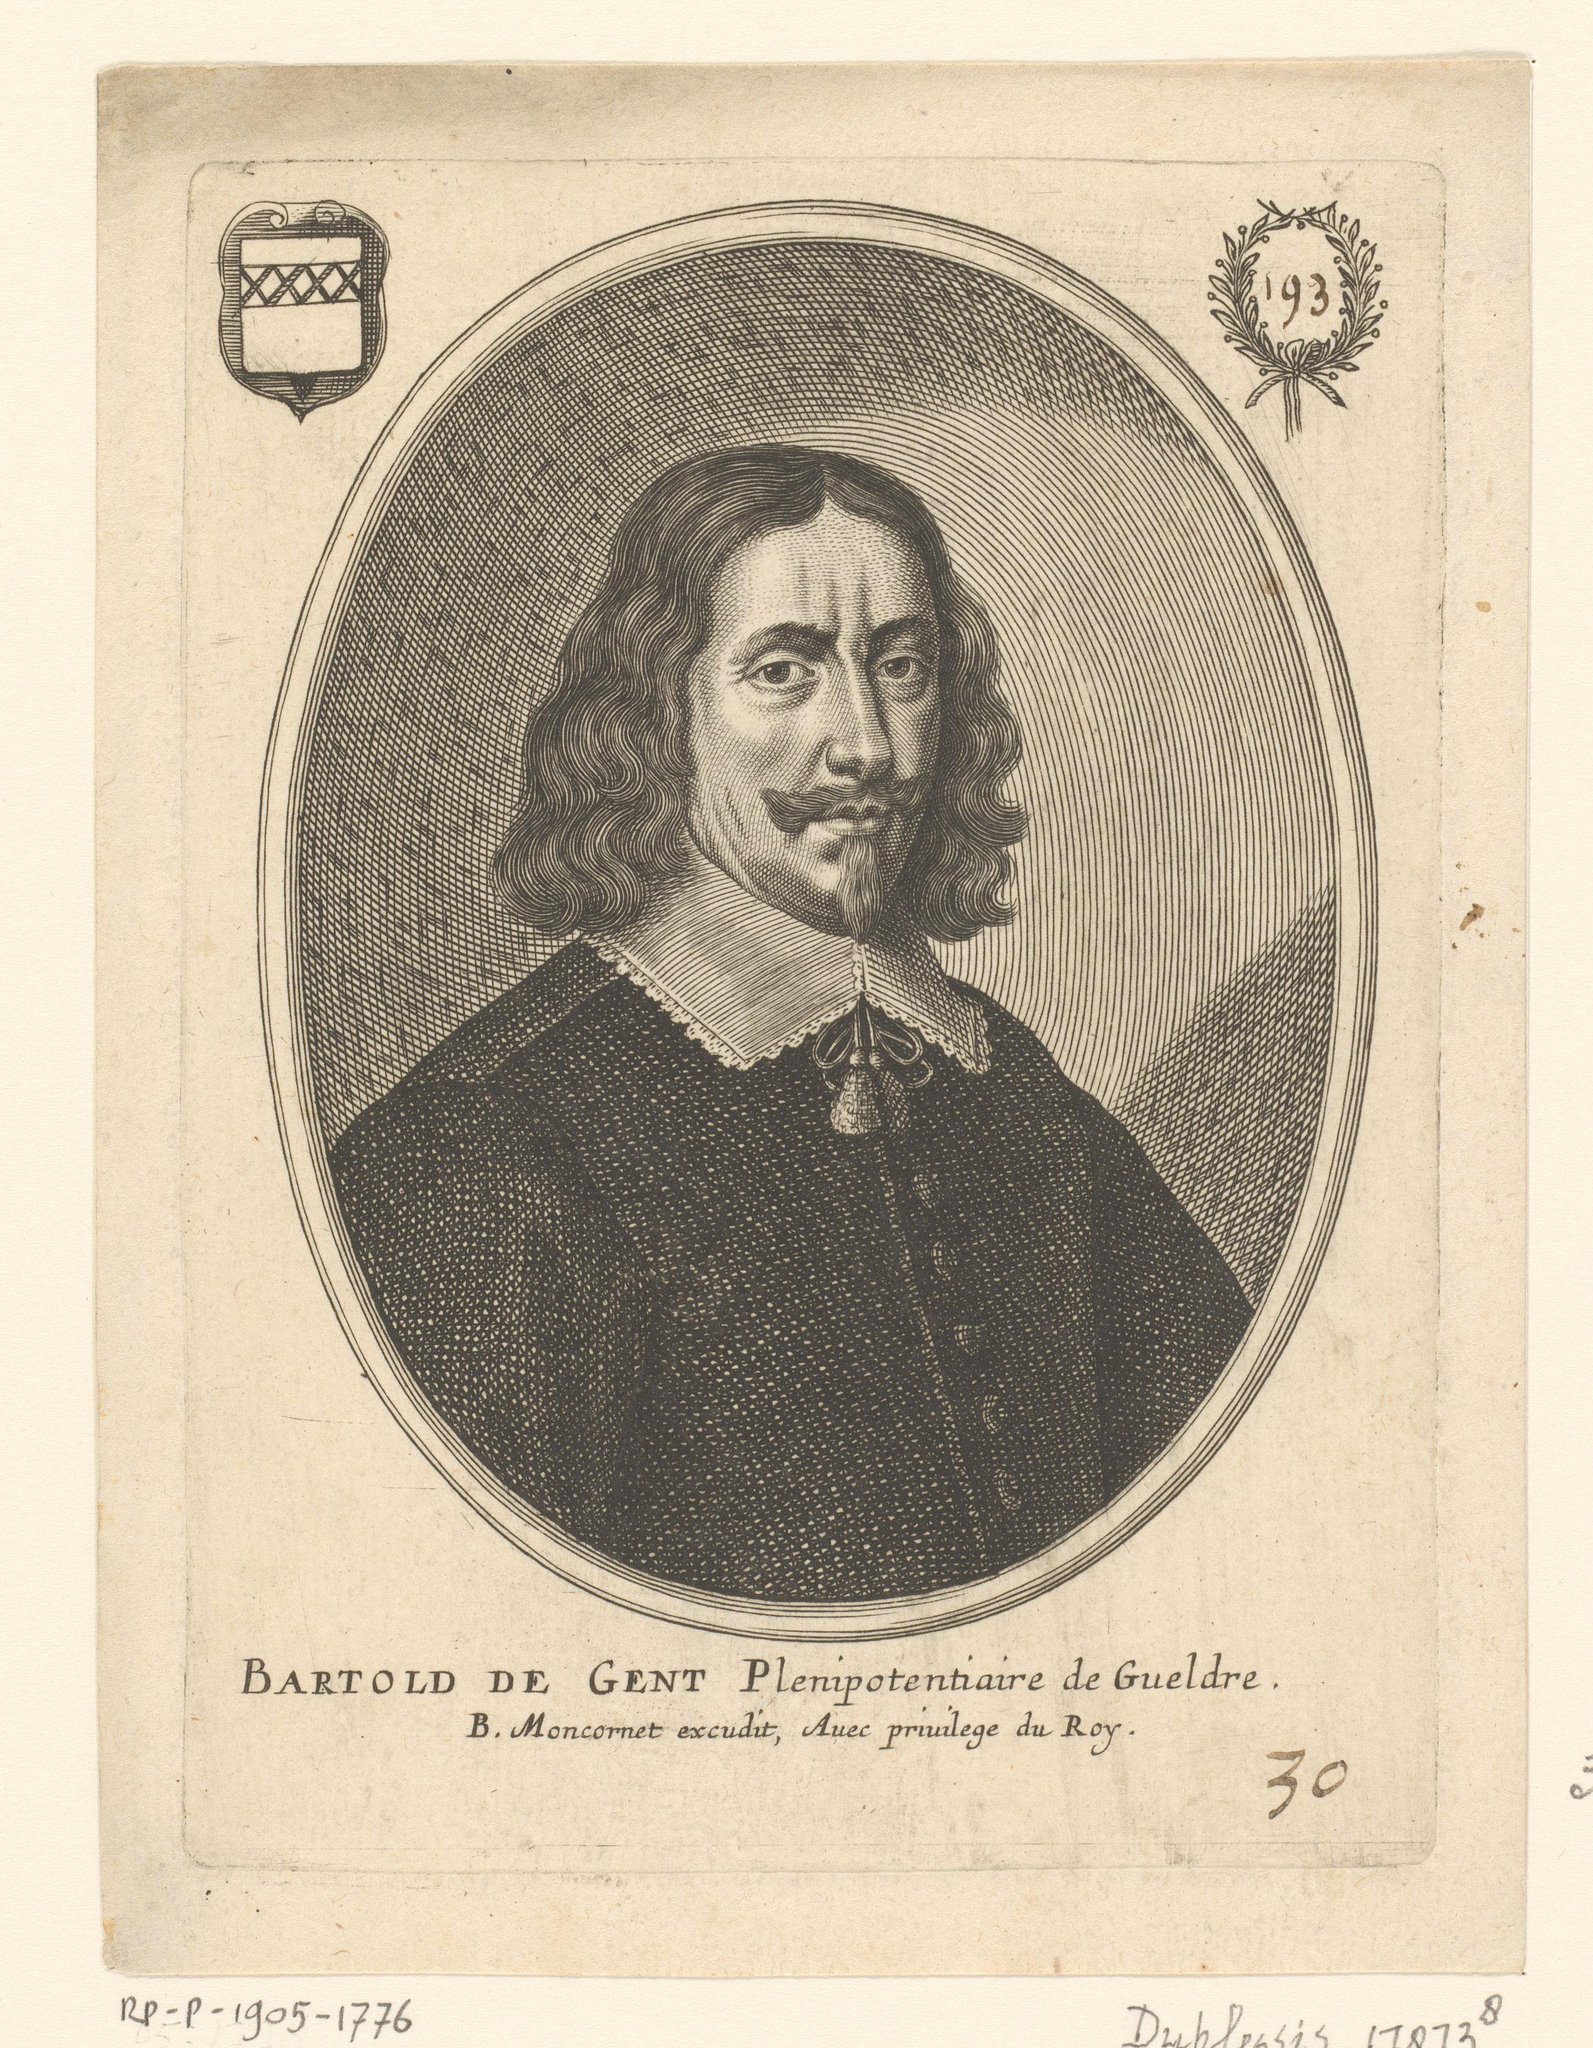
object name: print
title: Portraits, noms, et qualitez des ambassadeurs assemblez tant a Munster qu'Osnabruck (...)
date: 1646-1668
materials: paper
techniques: engraving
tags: historical persons, ambassador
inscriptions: inscription: ‘193’, inscription: ‘30’, collector's mark: Lugt 2228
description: De prent is waarschijnlijk een proefdruk van een prent die deel uit maakt van een serie van 35 prenten met portretten van de ambassadeurs van de Vrede van Westfalen.